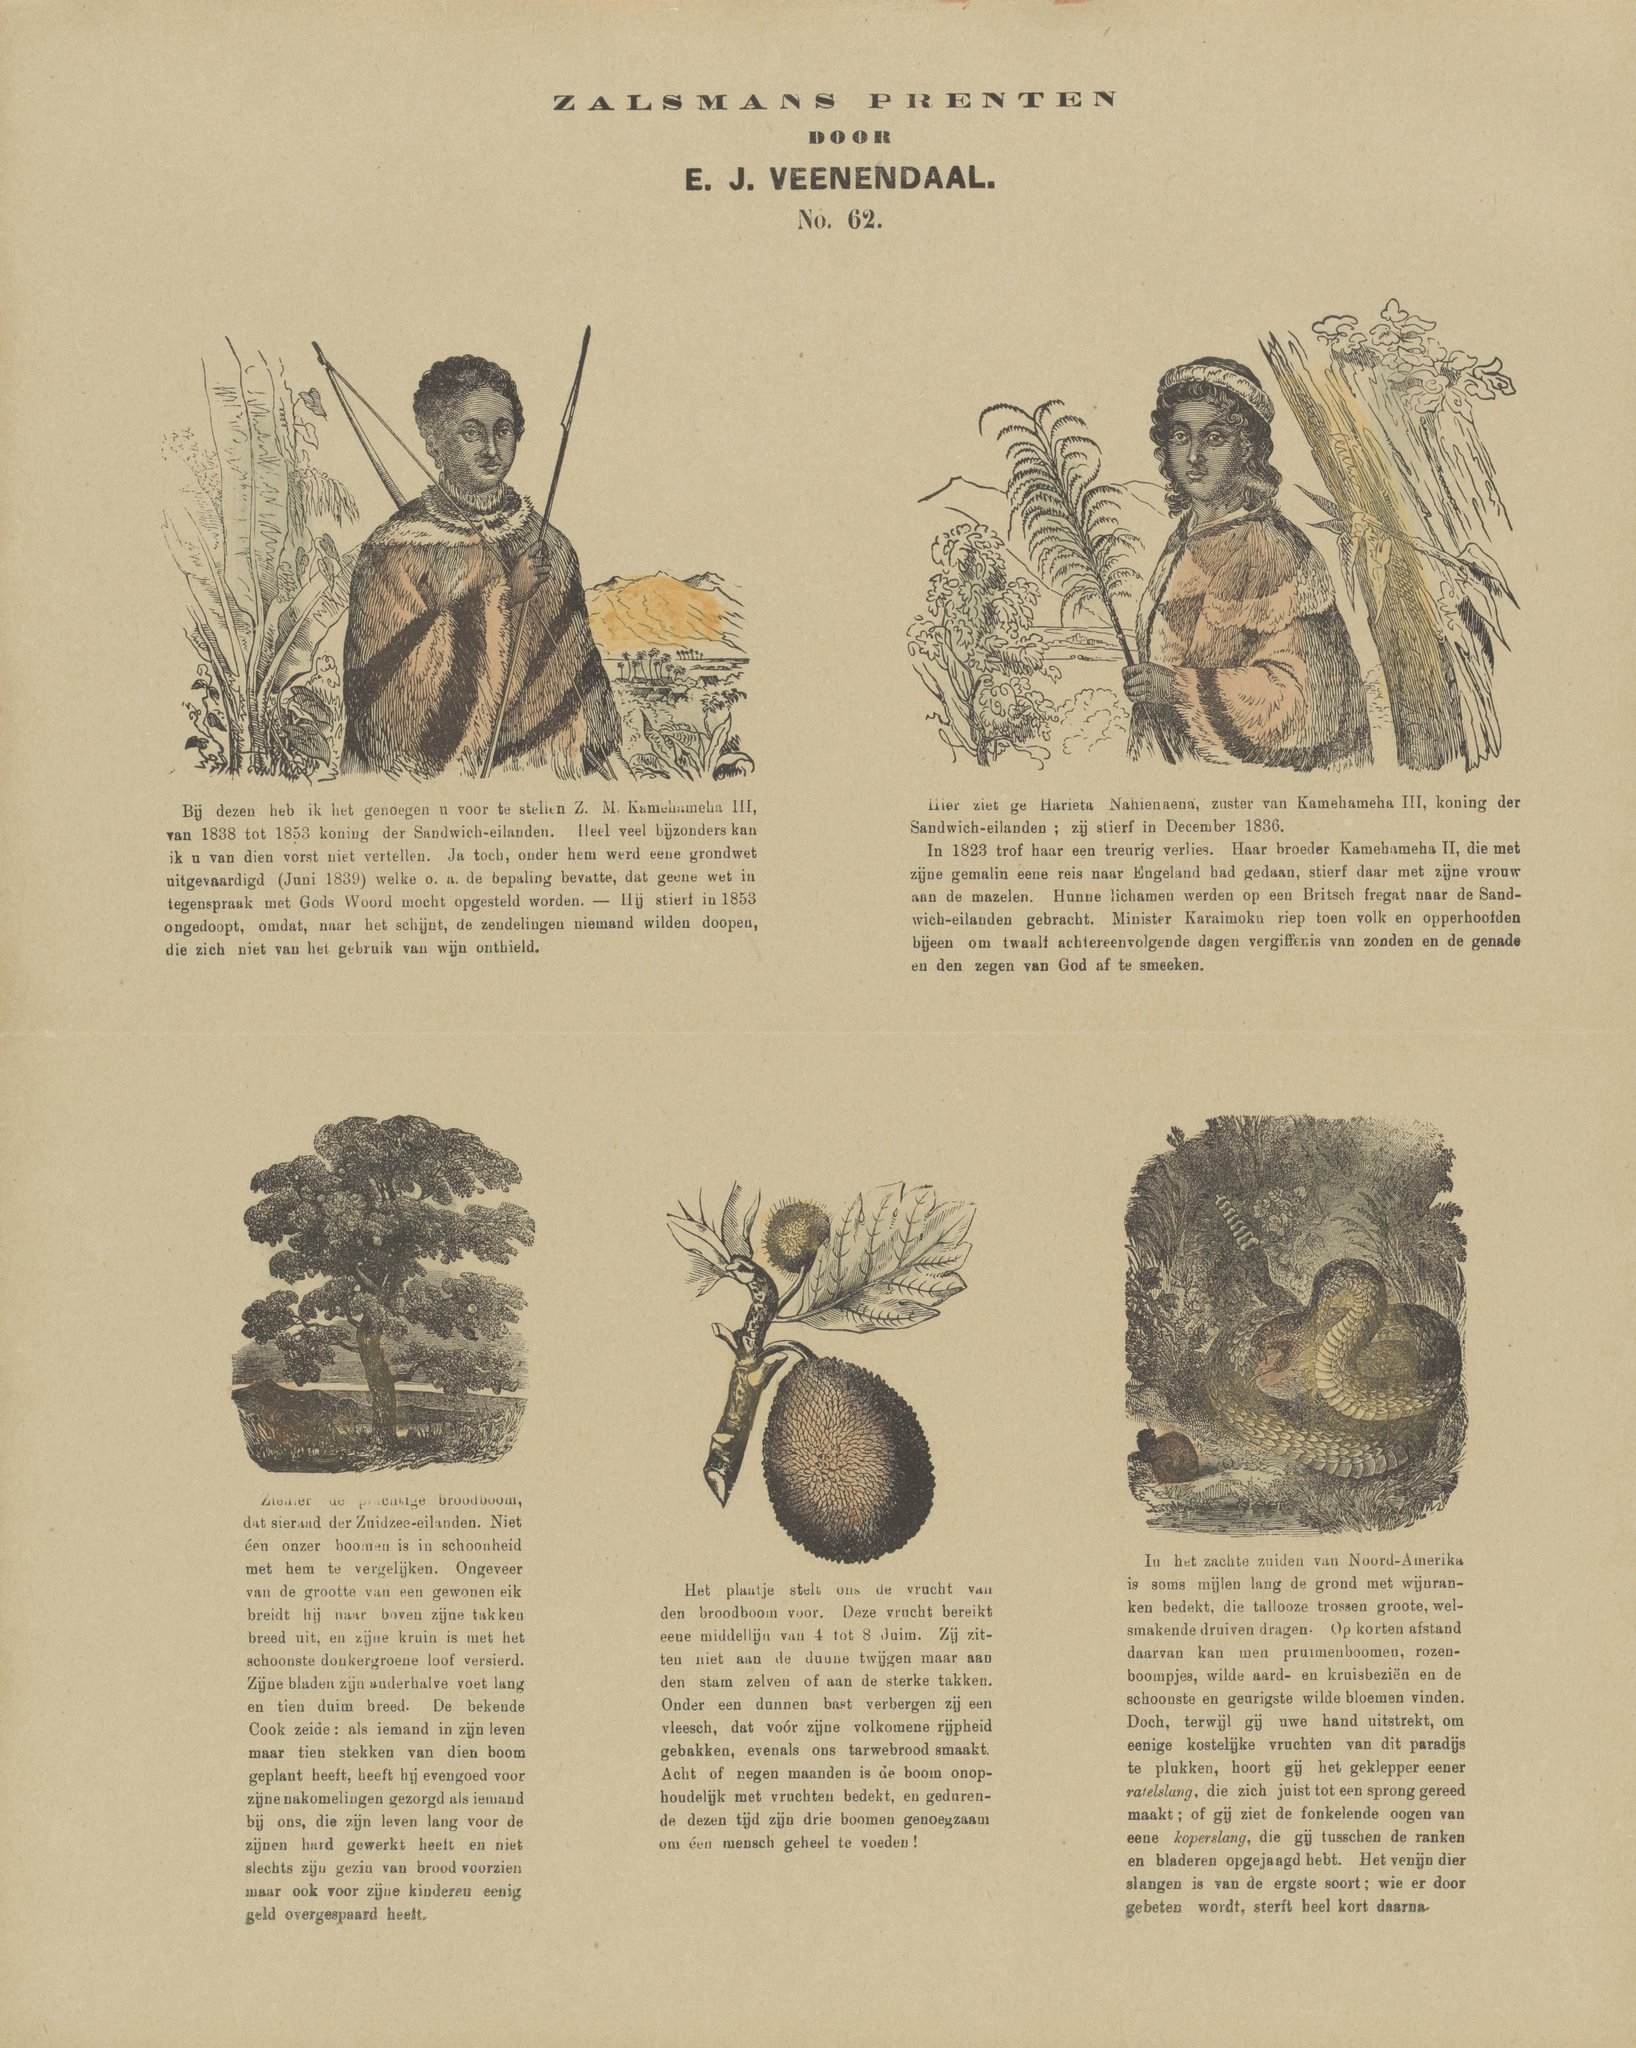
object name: print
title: Zalmans prenten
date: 1869-1882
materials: paper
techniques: colour, letterpress printing, engraving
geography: netherlands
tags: snakes, trees, ruler, sovereign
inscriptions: collector's mark: Lugt 2760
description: Blad met 5 voorstellingen van Kamehameha III en zijn zuster Nahiennaena, een boom, een vrucht en een slang. Onder elke afbeelding een onderschrift. Genummerd midden boven: No. 62.